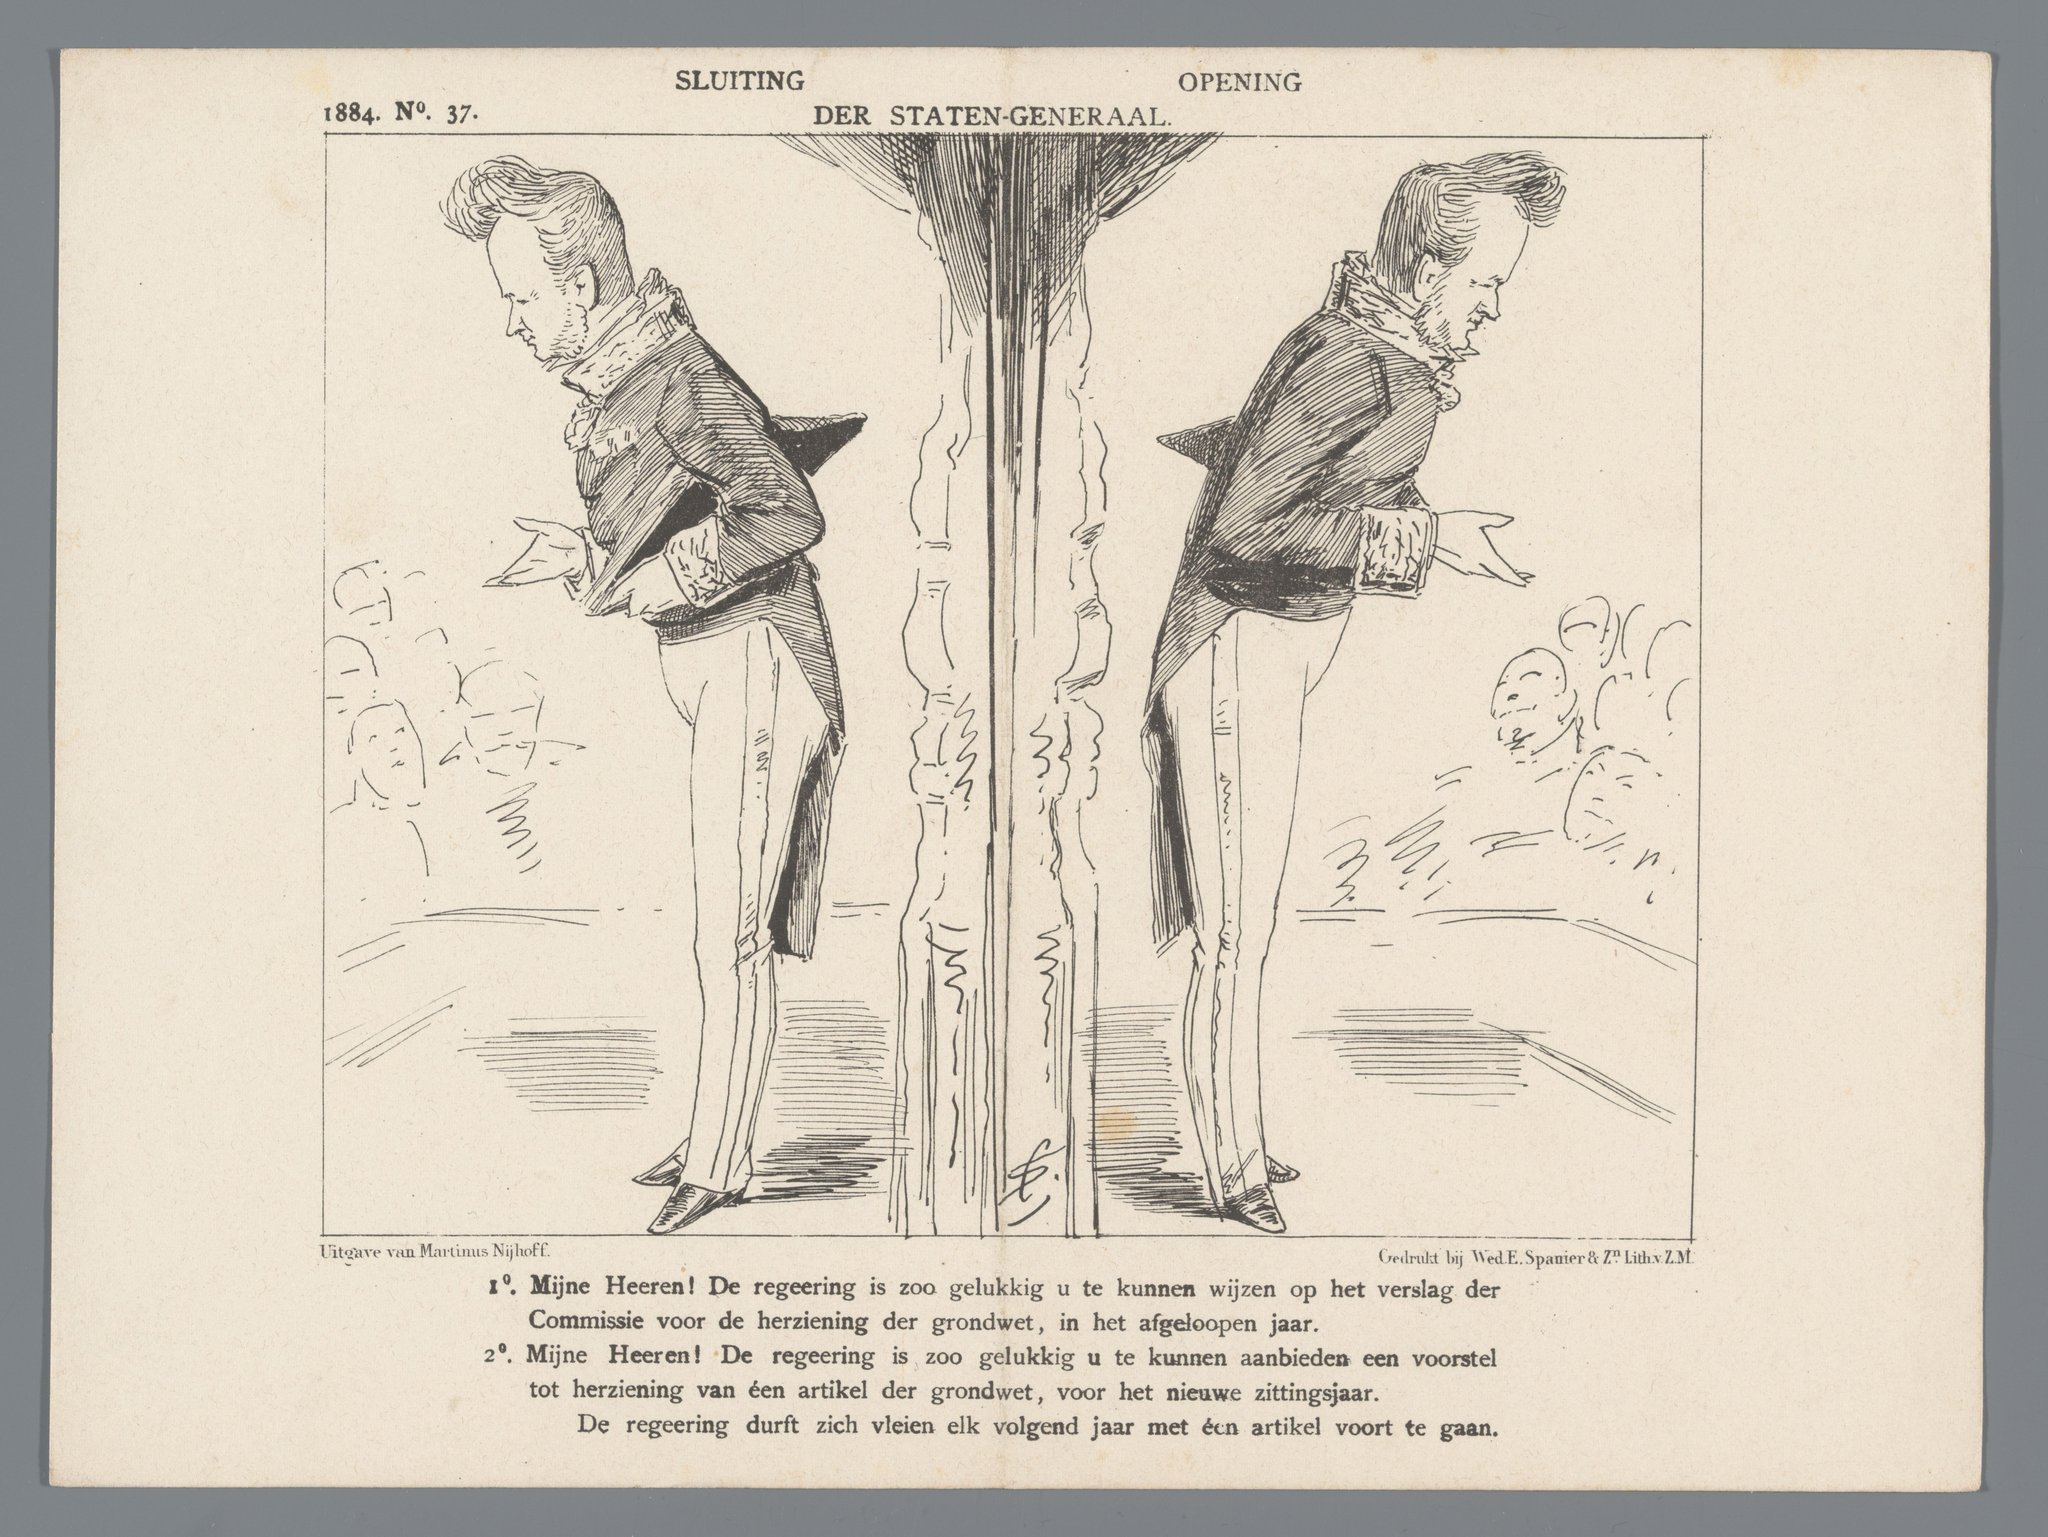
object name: print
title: Sluiting / Opening der Staten-Generaal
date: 1884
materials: paper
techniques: lithograph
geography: the hague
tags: tweede kamerlid, minister van binnenlandse zaken, minister van justitie, jan heemskerk azn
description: Spotprent over de sluiting en opening van der Staten-Generaal, 1884. Plaat verschenen bij het weekblad De Nederlandsche Spectator, nr. 37, 1884.